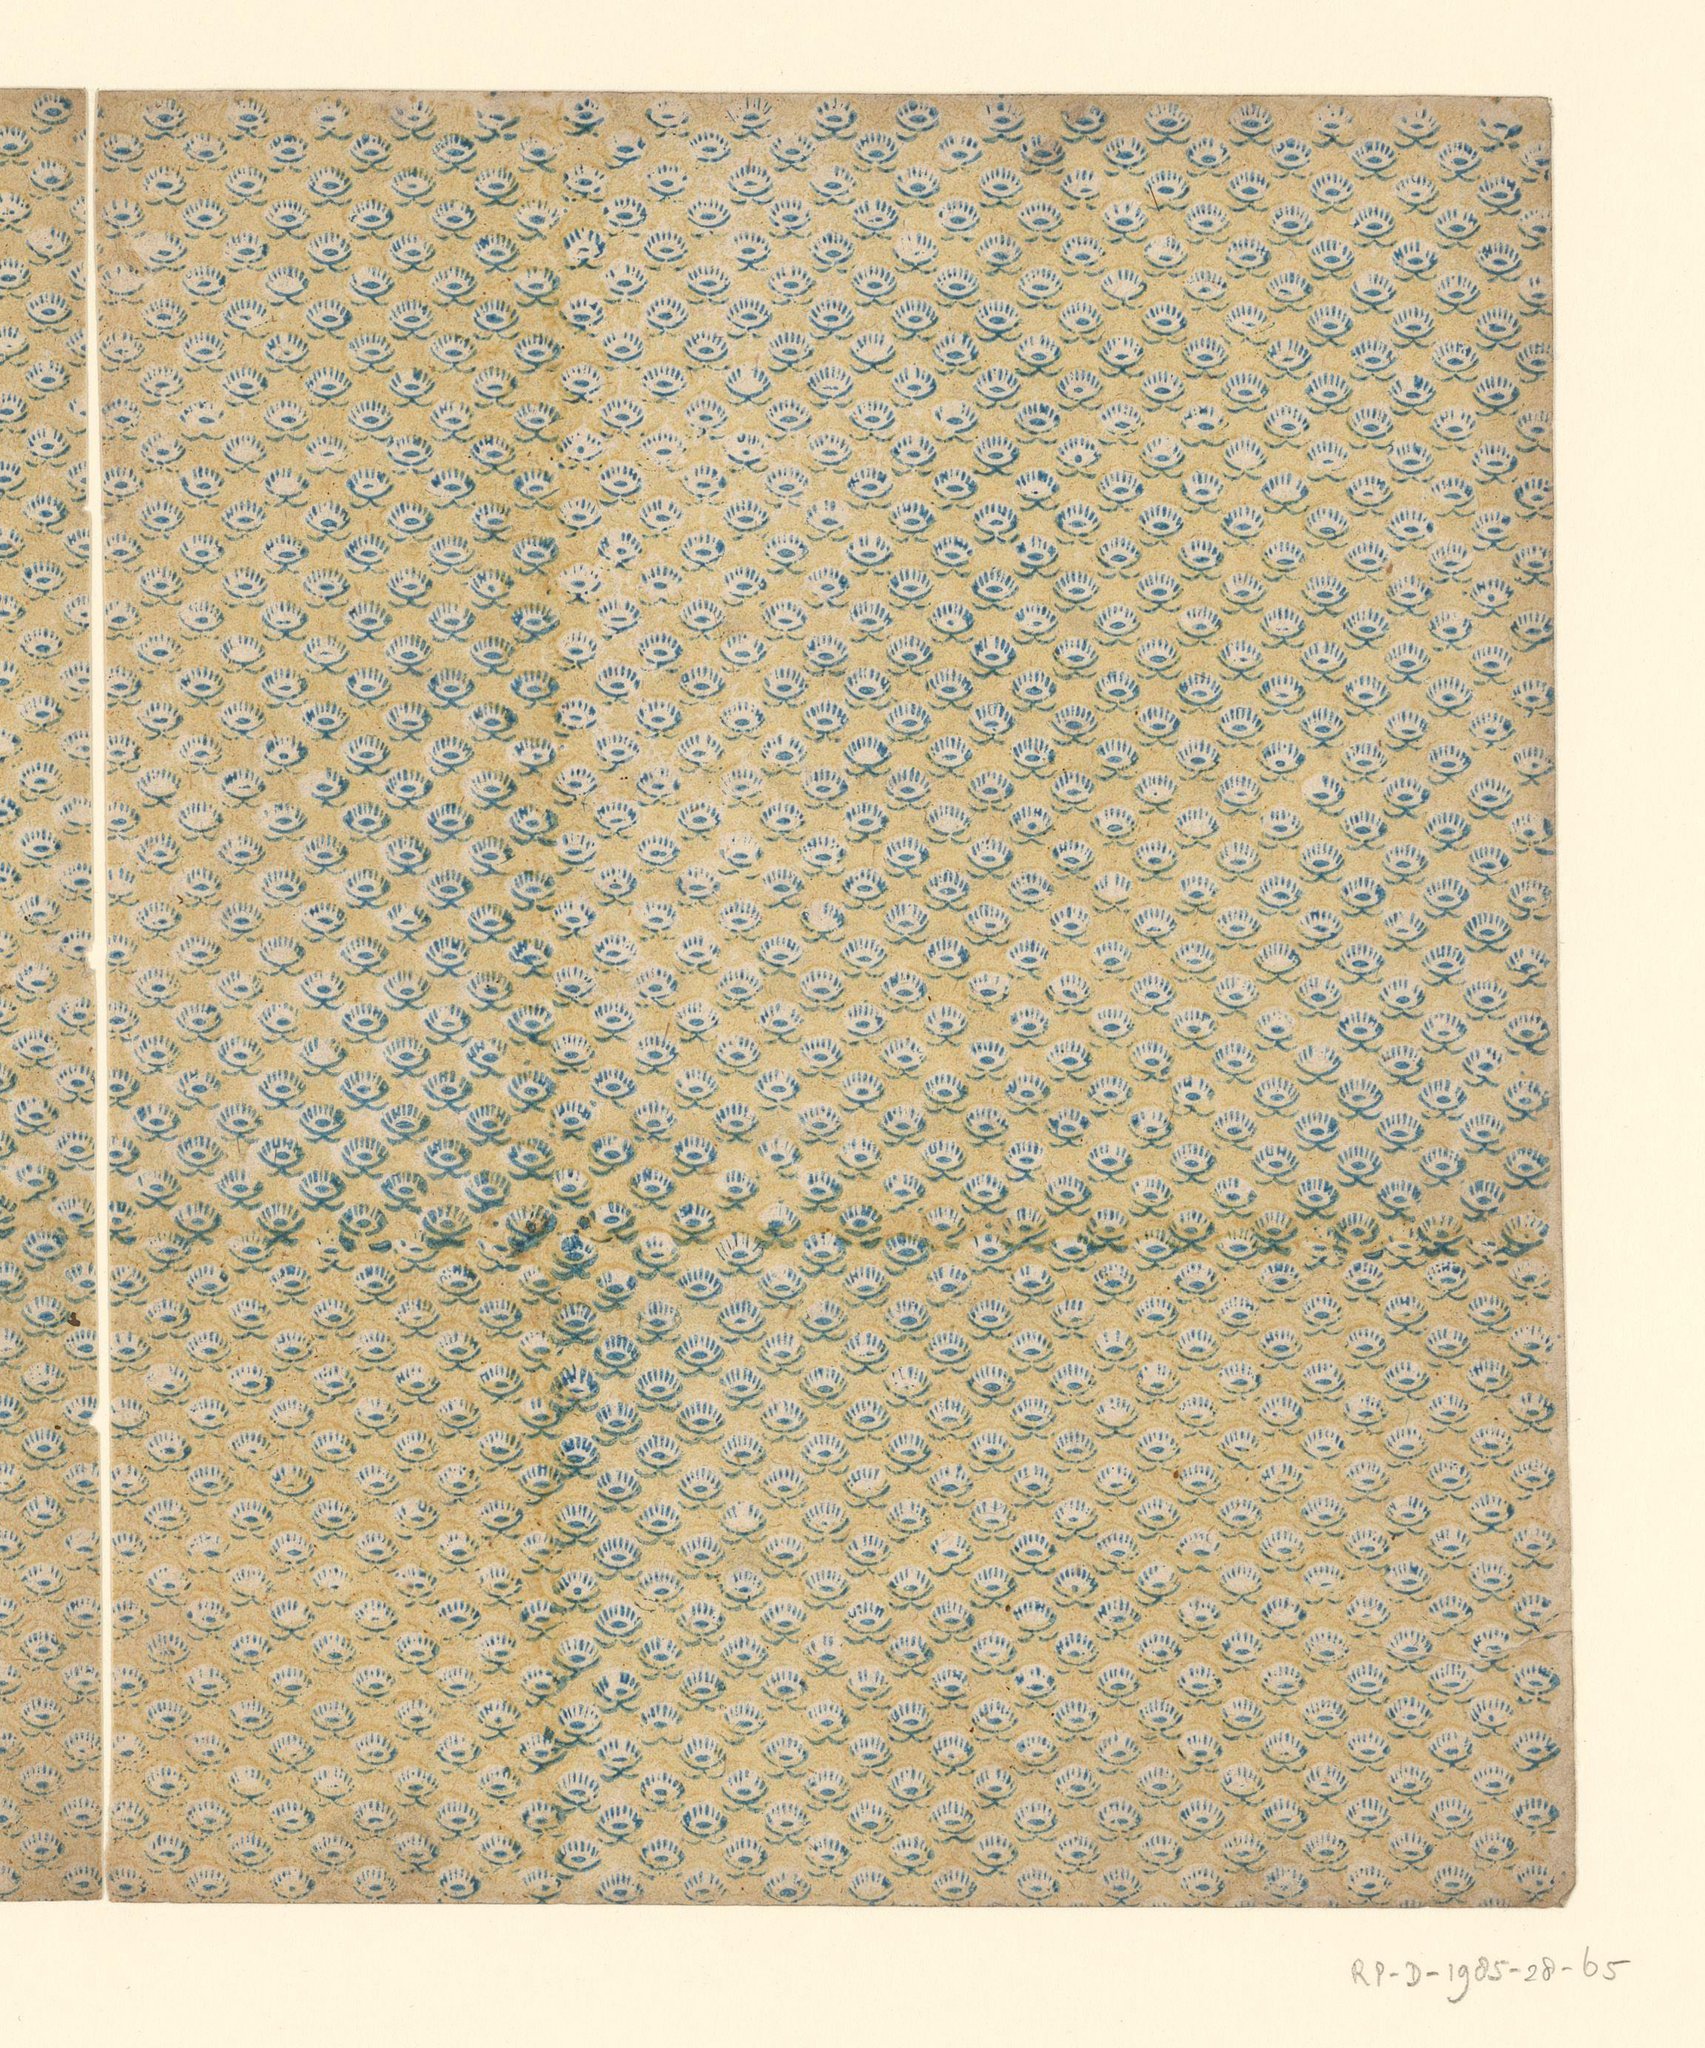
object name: printed paper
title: Strooipatroon van een bloemmotief in blauw op een geel fond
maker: Anonymous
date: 1750-1900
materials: paper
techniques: printing block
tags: ornament derived from plant forms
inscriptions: collector's mark: Lugt 2228, collector's mark: Lugt 2760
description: Blad met strooipatroon van een bloemmotief. Helft van een omslag.